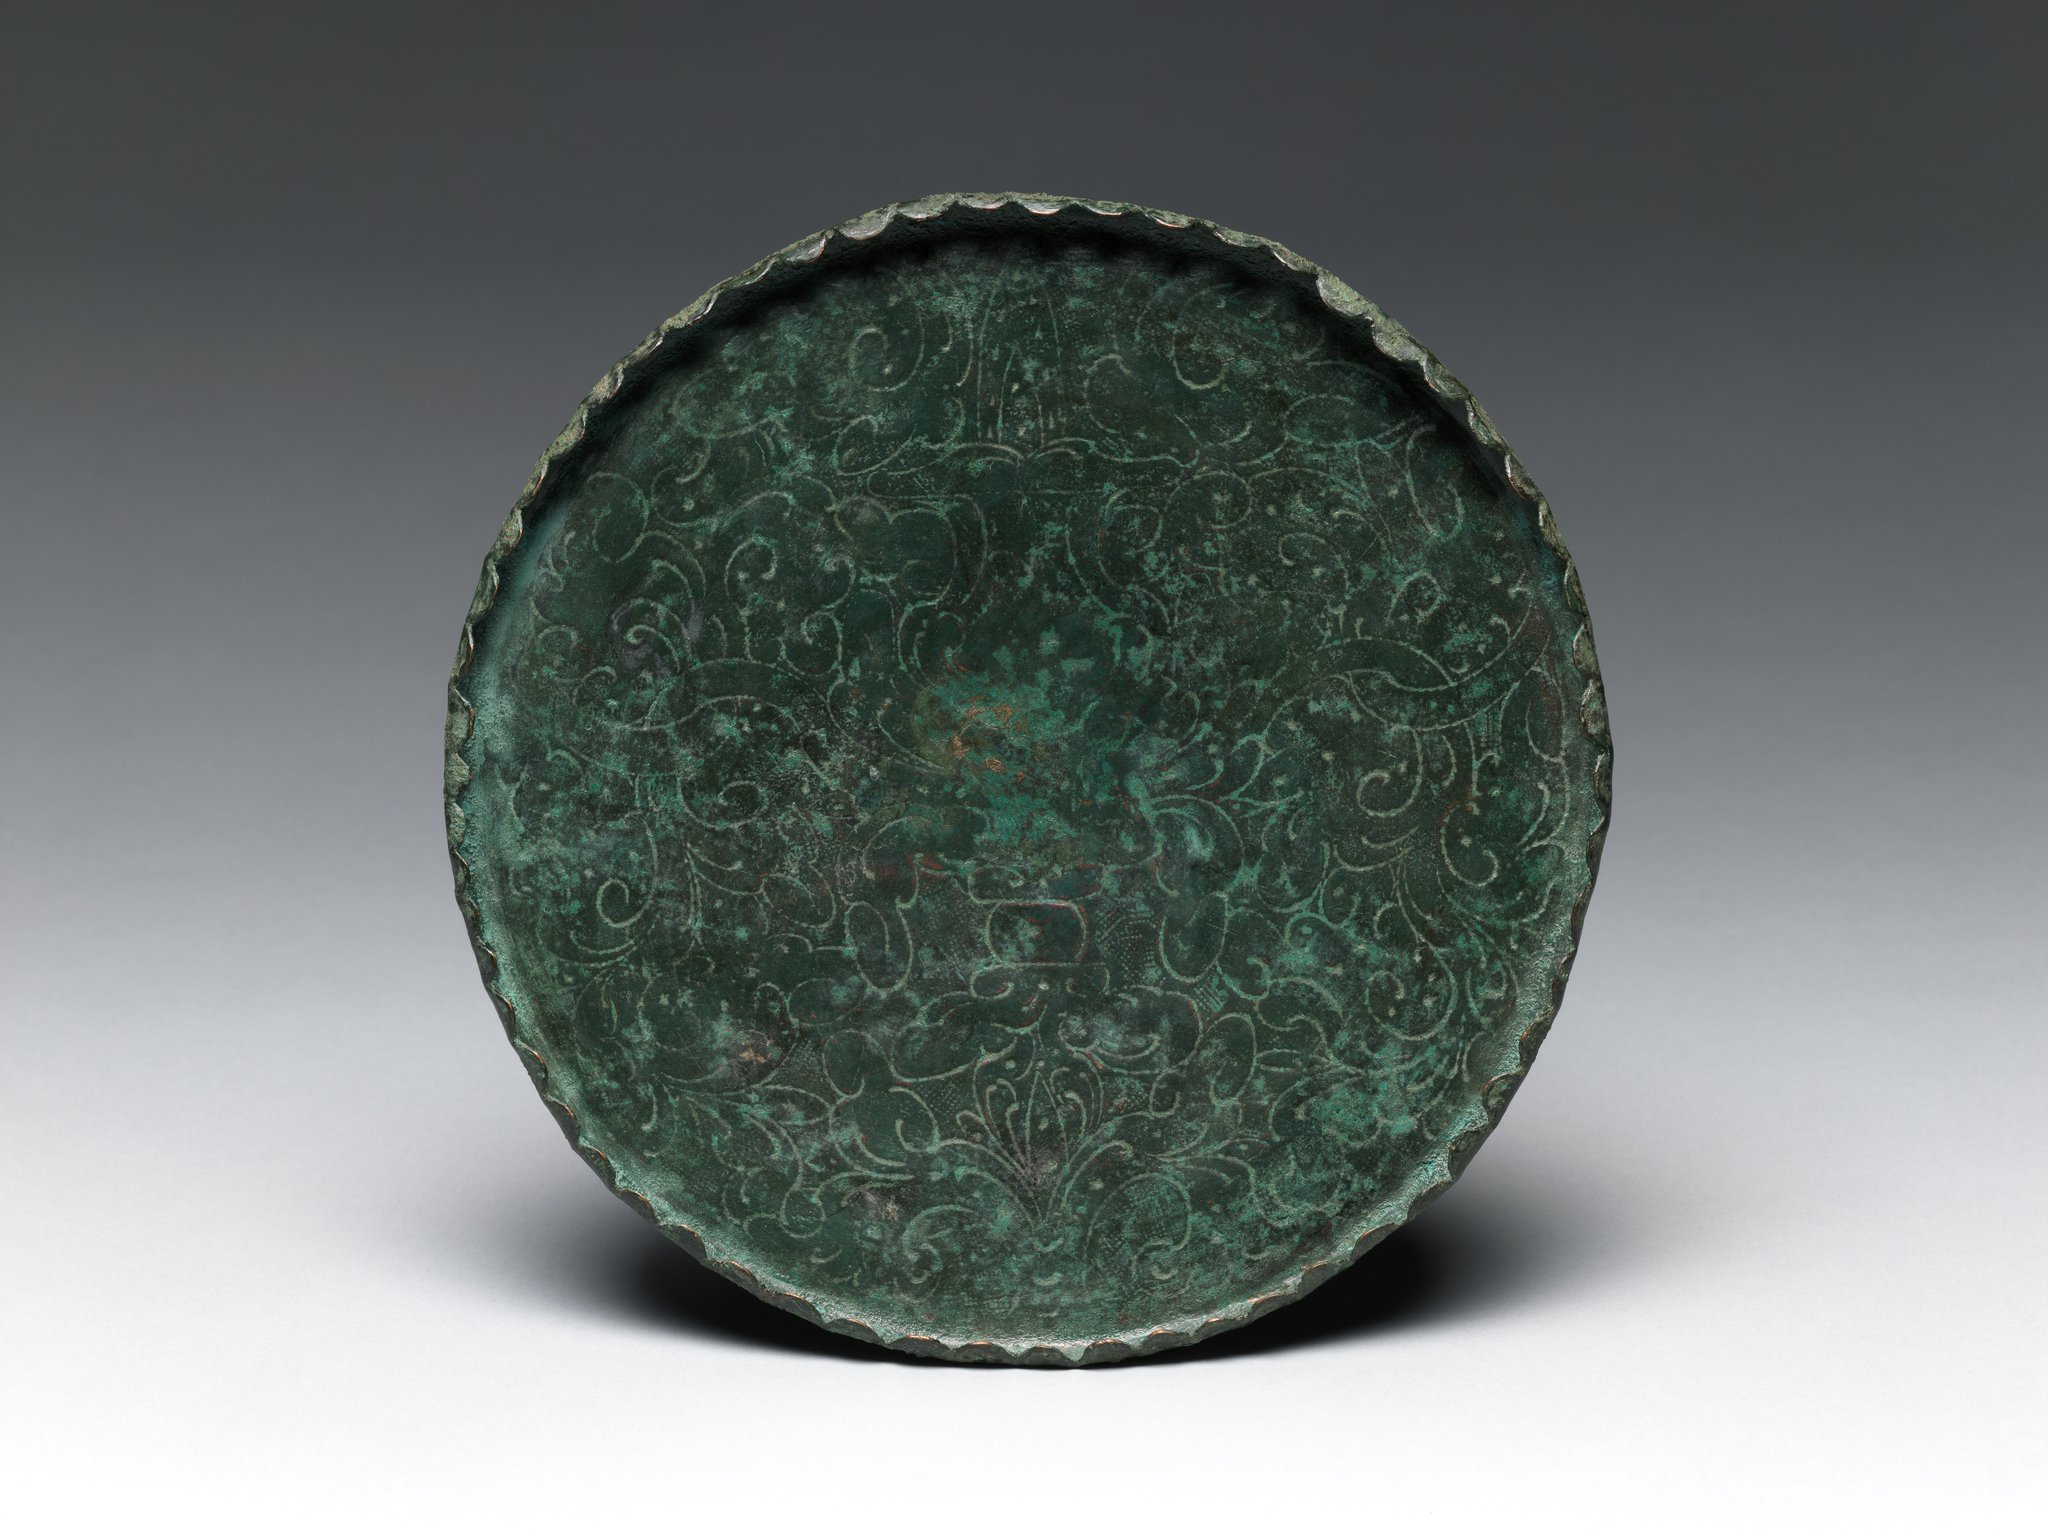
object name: offering tray talam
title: Offering Tray (Talam)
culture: indonesian, javanese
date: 901-1100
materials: bronze